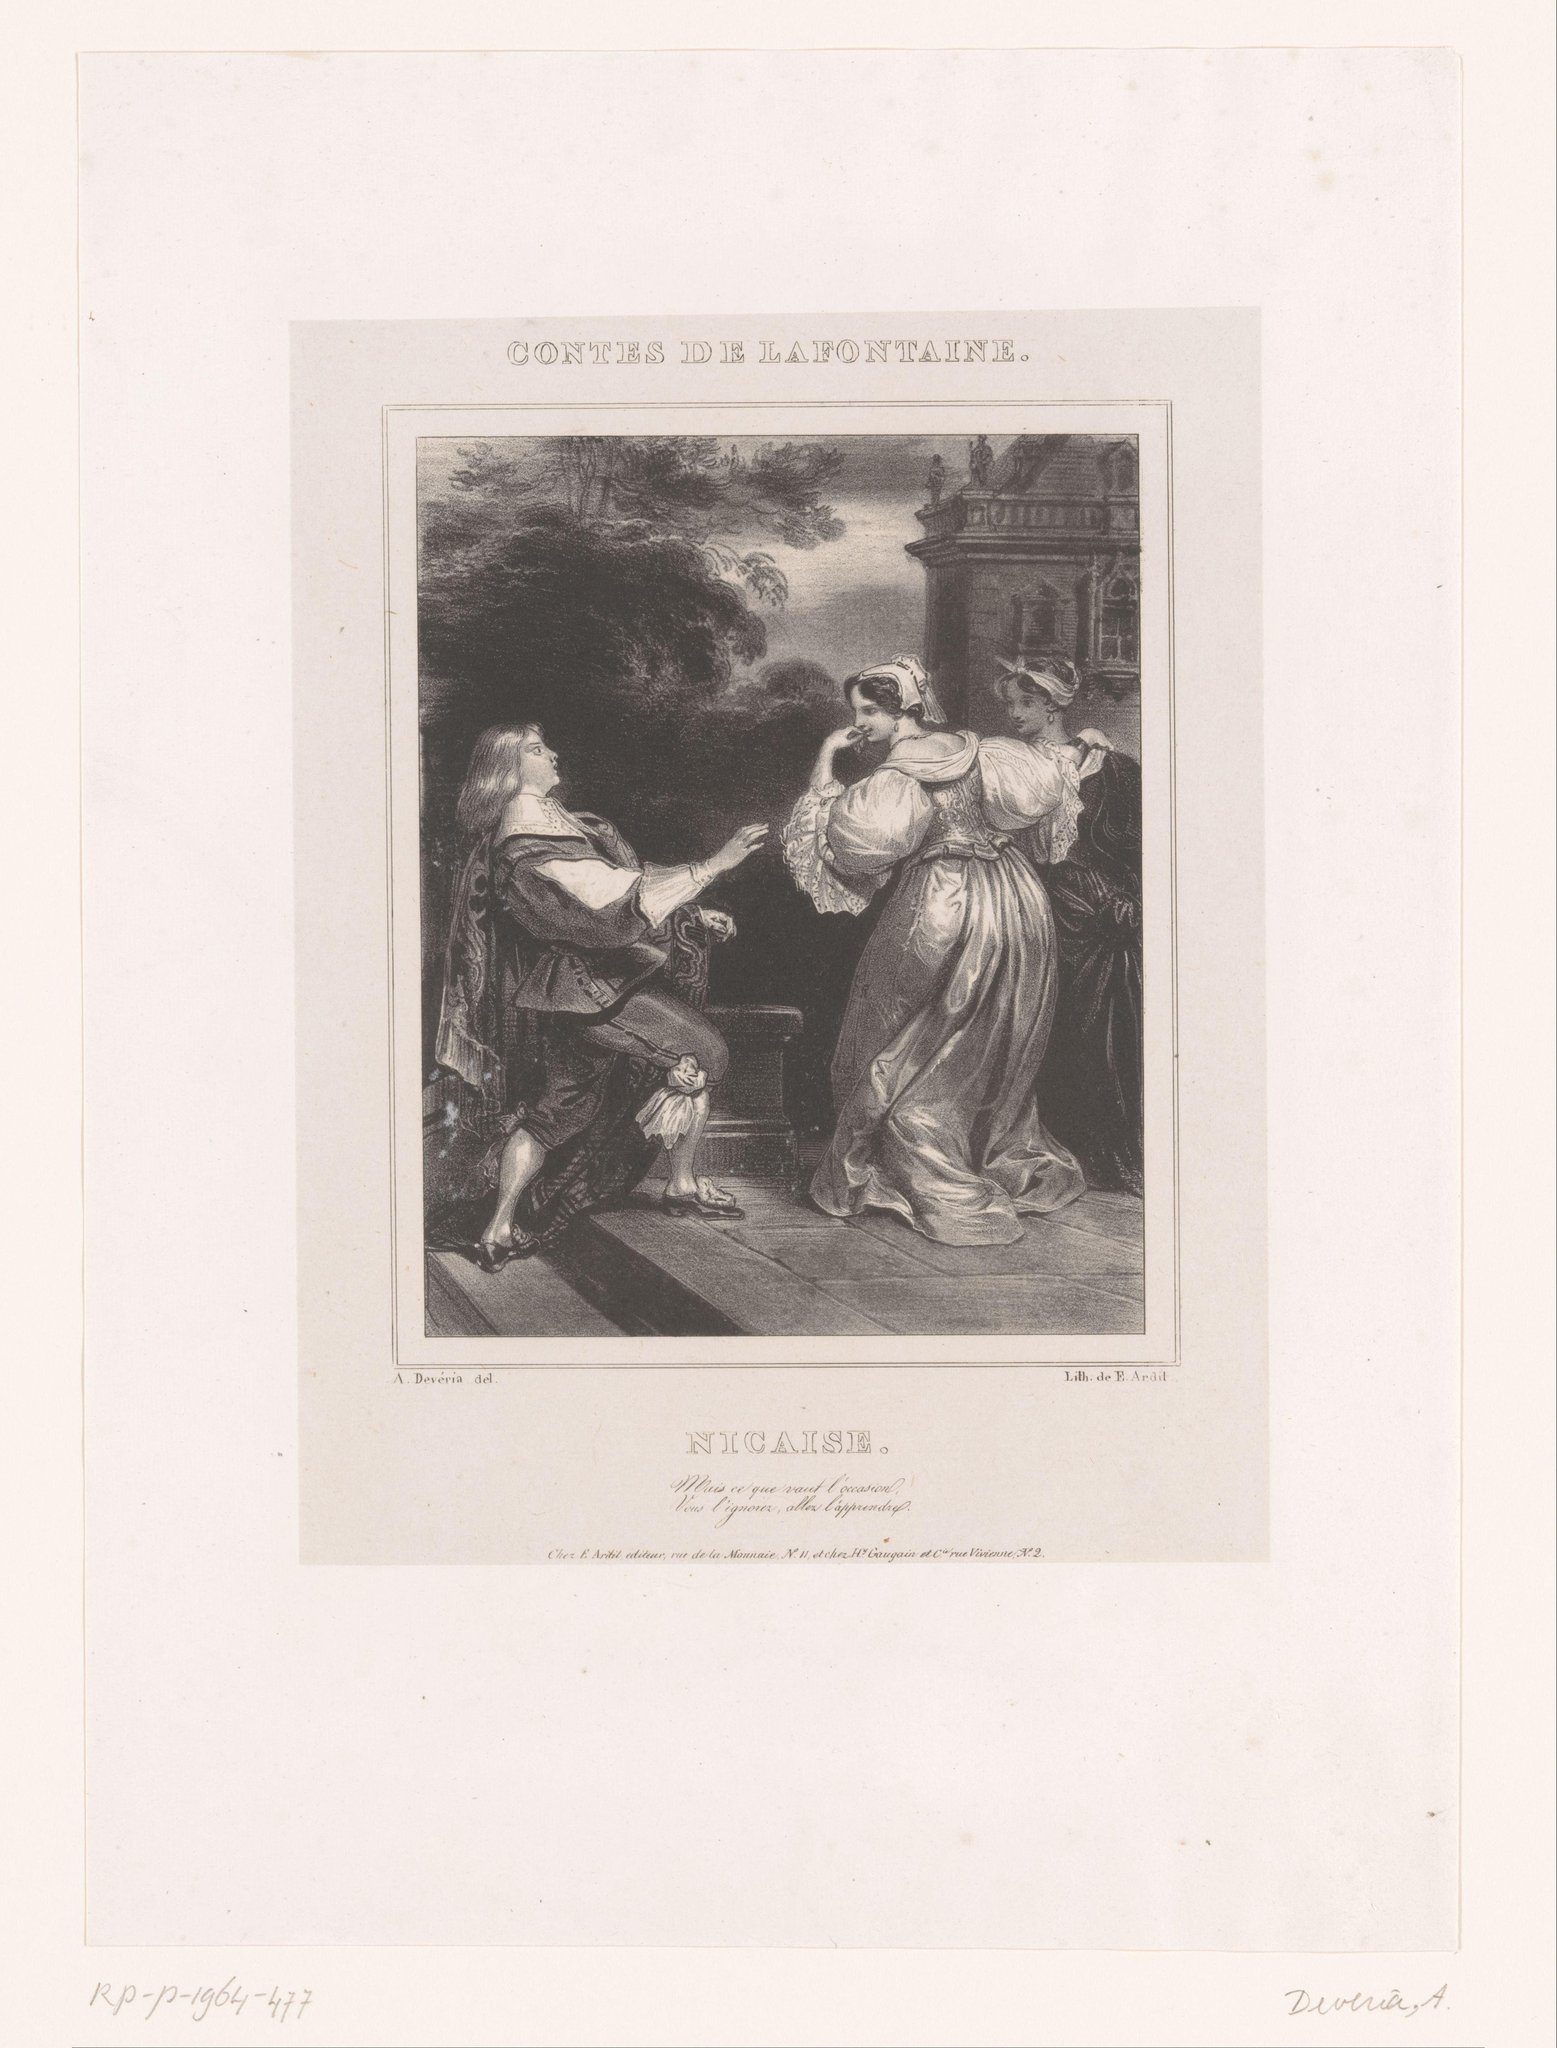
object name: print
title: Verhalen van Jean de La Fontaine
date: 1823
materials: paper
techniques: lithograph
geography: paris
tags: pursuit of a woman, prowling, being refused, the proposal rejected, lovers' meeting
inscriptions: collector's mark: Lugt 2228a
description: De scène komt uit 'Nicaise', een gedicht van Jean de La Fontaine.